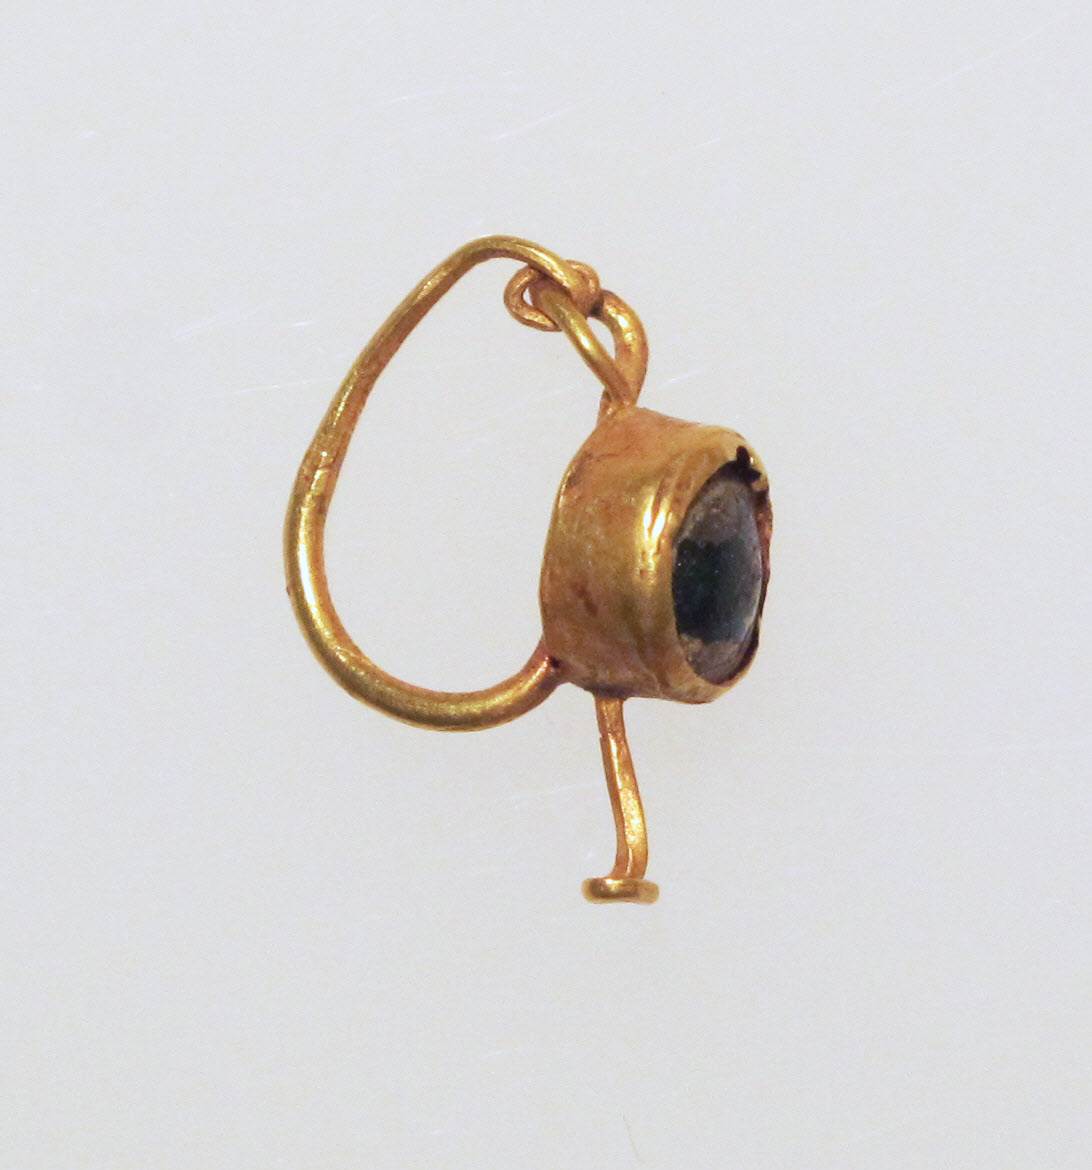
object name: earring with glass setting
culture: roman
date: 1-300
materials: glass, gold, paste